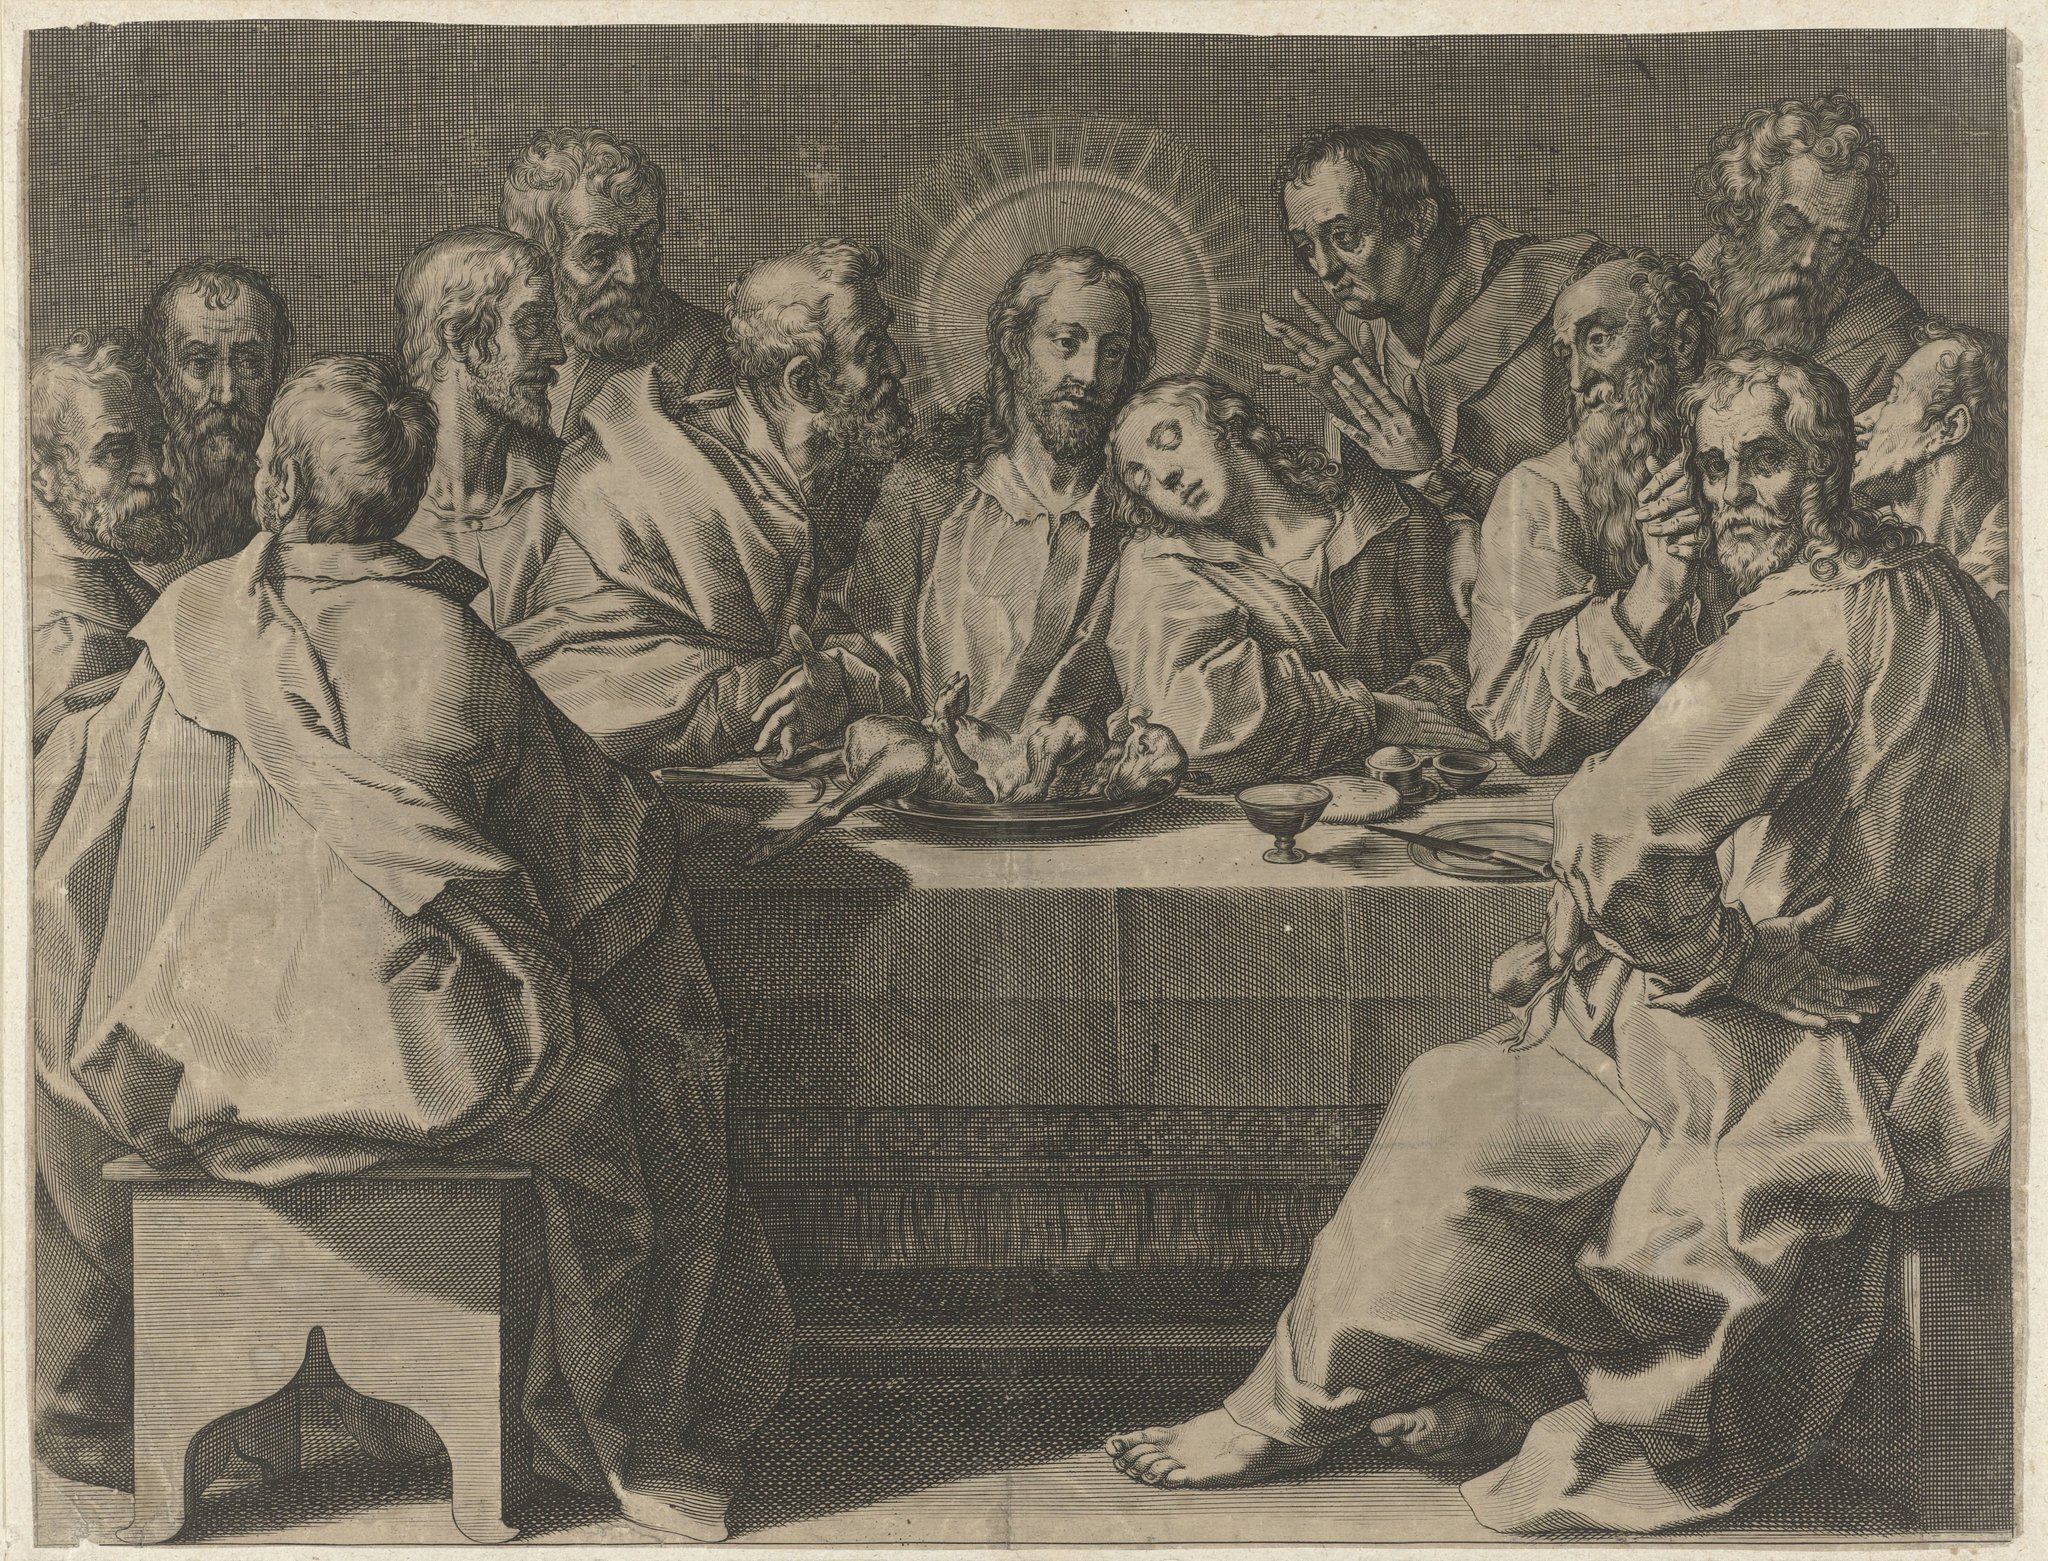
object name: print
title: Coeni domini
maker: Anonymous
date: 1560-1650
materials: paper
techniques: engraving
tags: last supper (in general) (matthew 26:21-35; mark 14:18-31; luke 22:3, 22:15-23; john 13:21-38)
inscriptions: collector's mark: Lugt 240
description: Christus en zijn leerlingen rondom een rechthoekige tafel. Johannes met zijn hoofd op Christus' schouder. Judas, centraal vooraan, met een geldbuidel aan zijn gordel, symbool van zijn verraad. De prent heeft een Latijns onderschrift met een vers uit de Bijbel (Luc. 22).